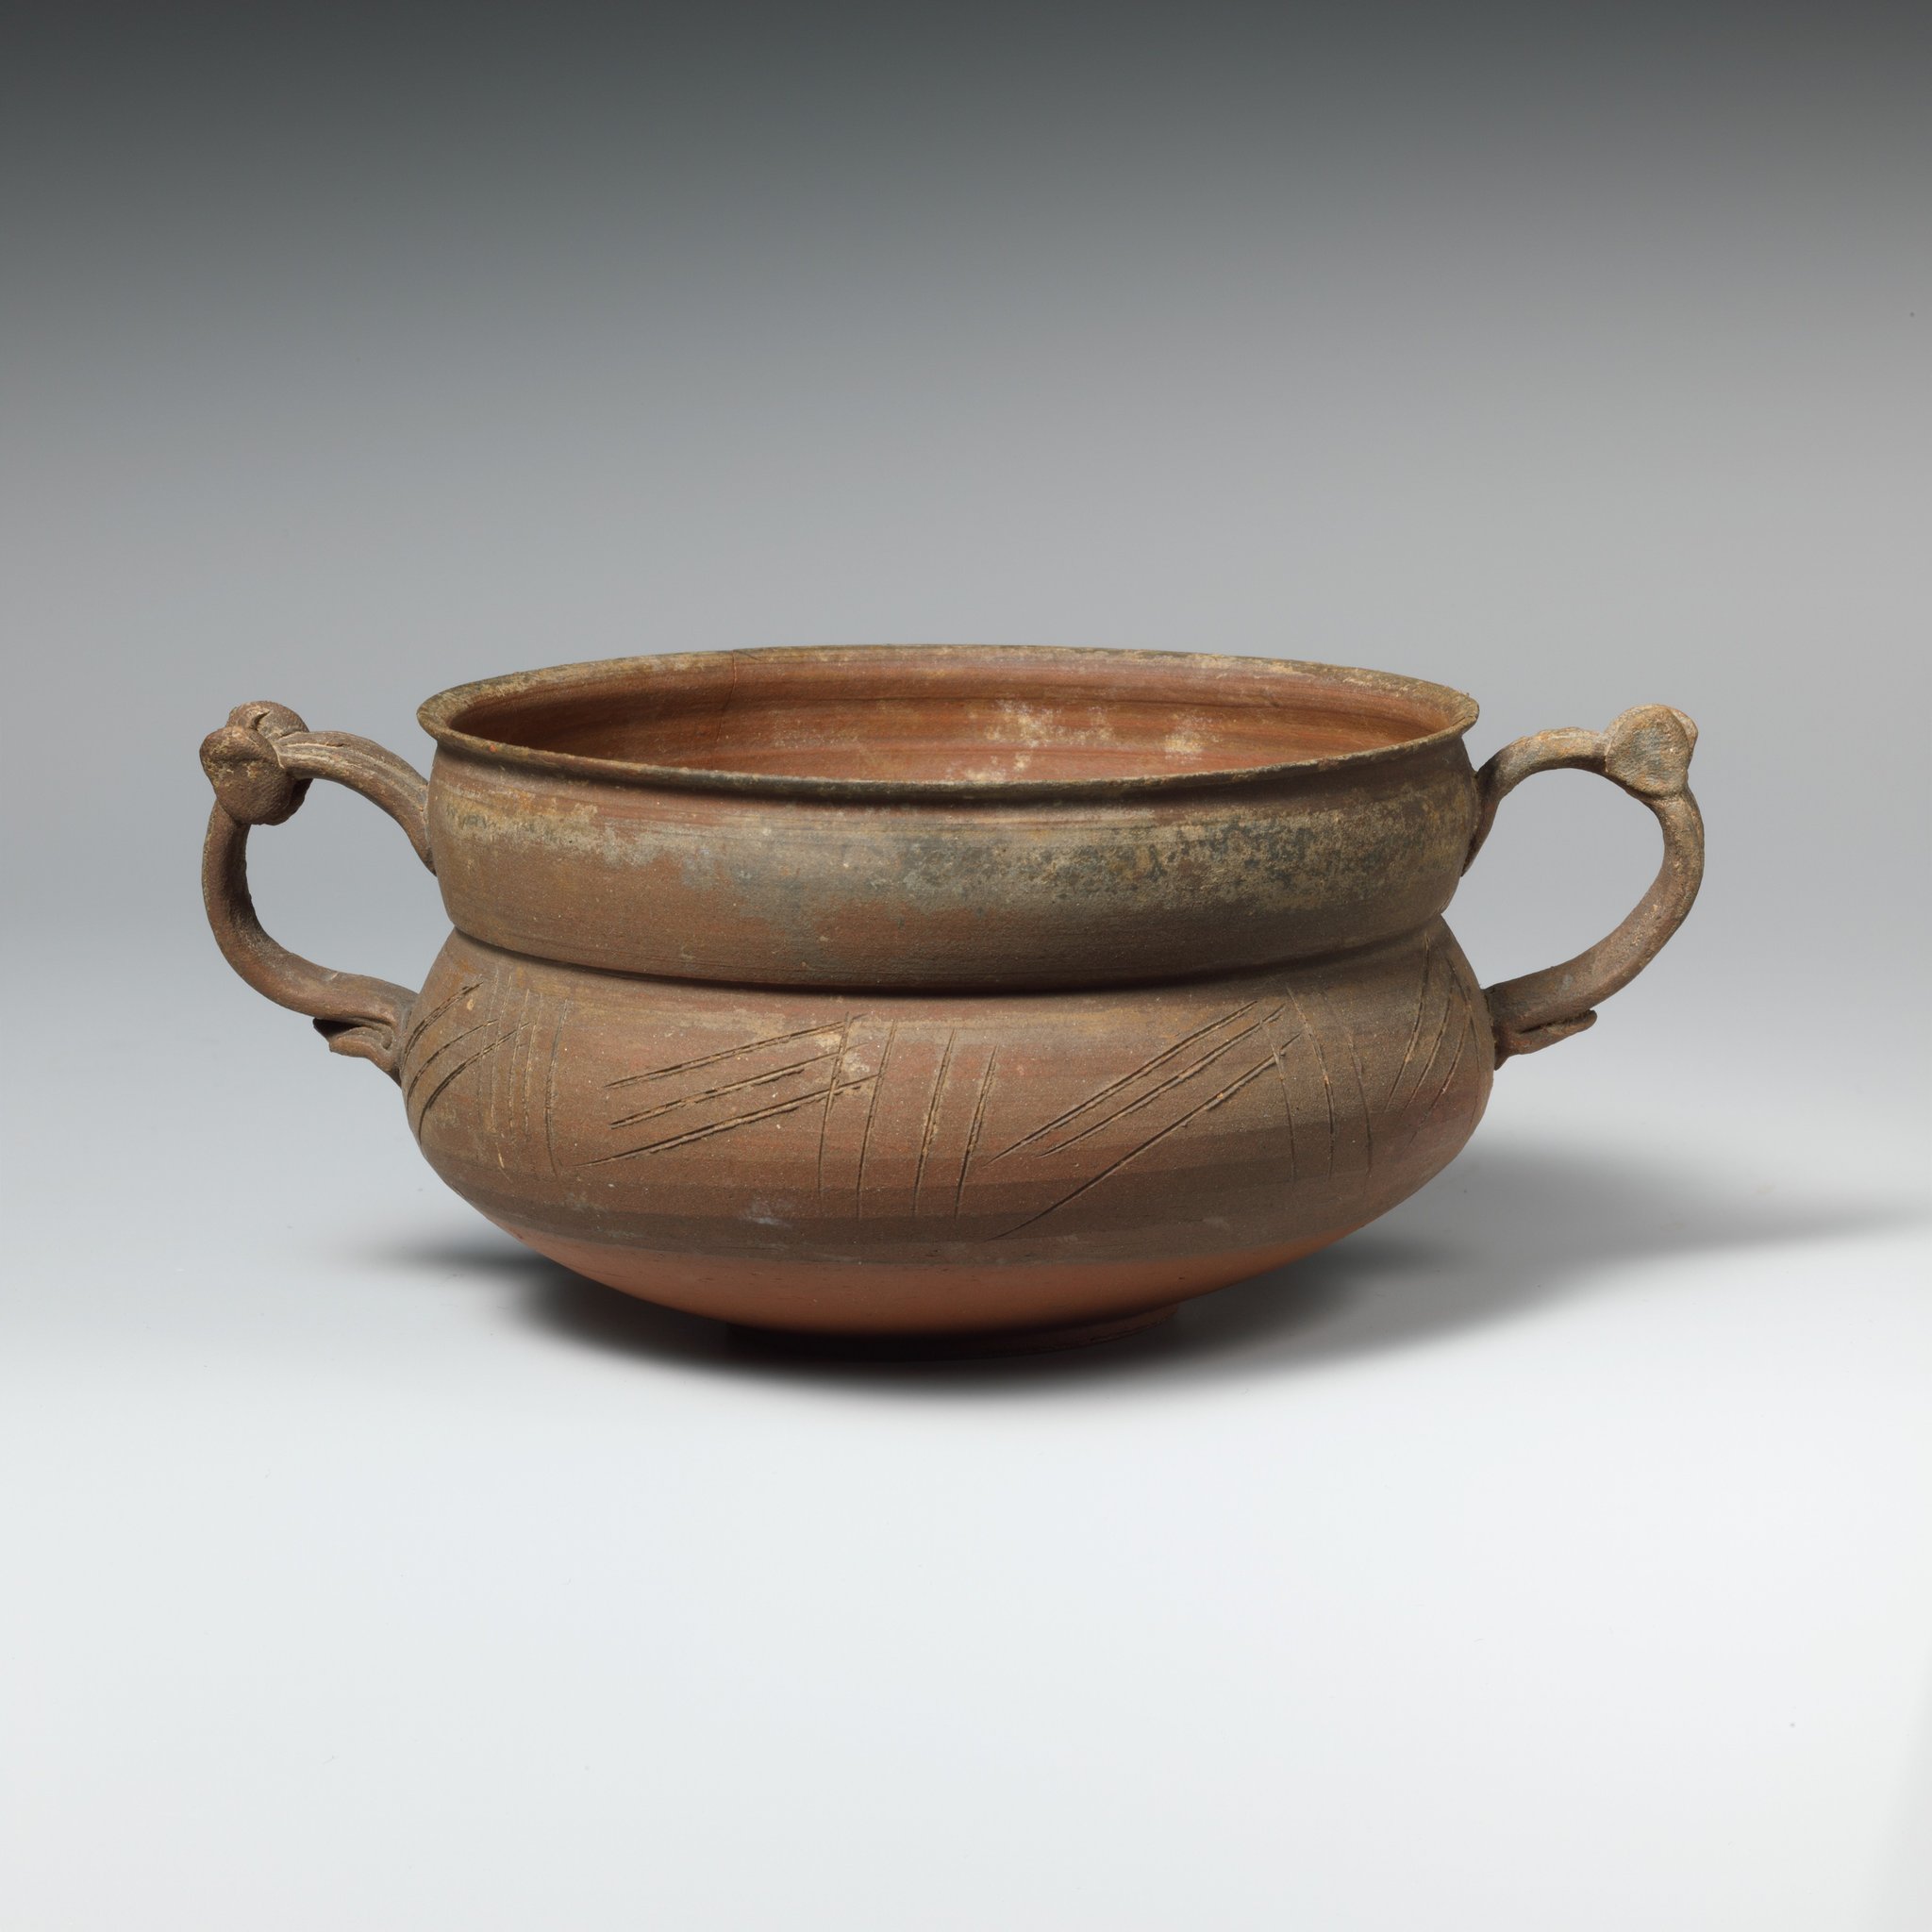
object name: skyphos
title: Terracotta cup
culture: roman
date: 1-33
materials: terracotta